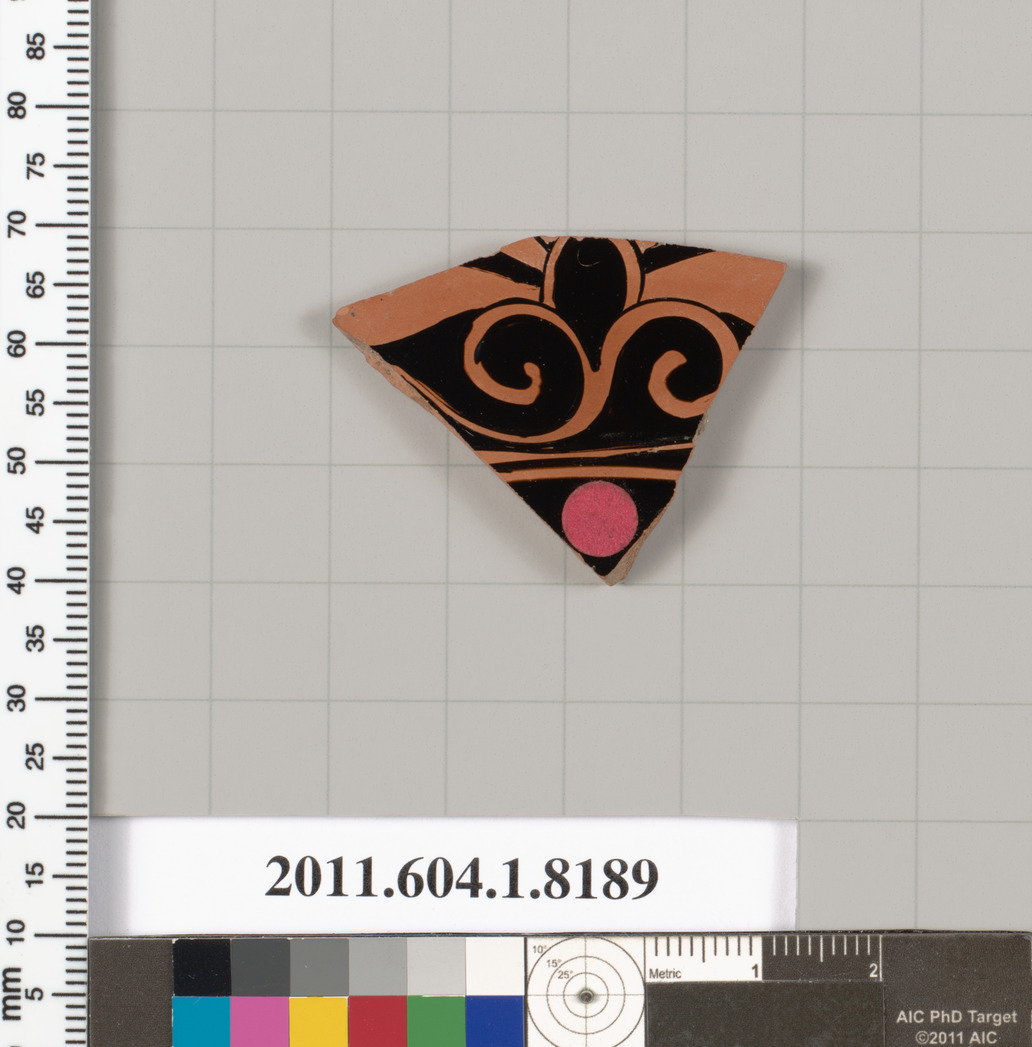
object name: kylix fragment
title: Terracotta fragment of a kylix (drinking cup)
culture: greek, attic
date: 534-468 BCE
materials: terracotta